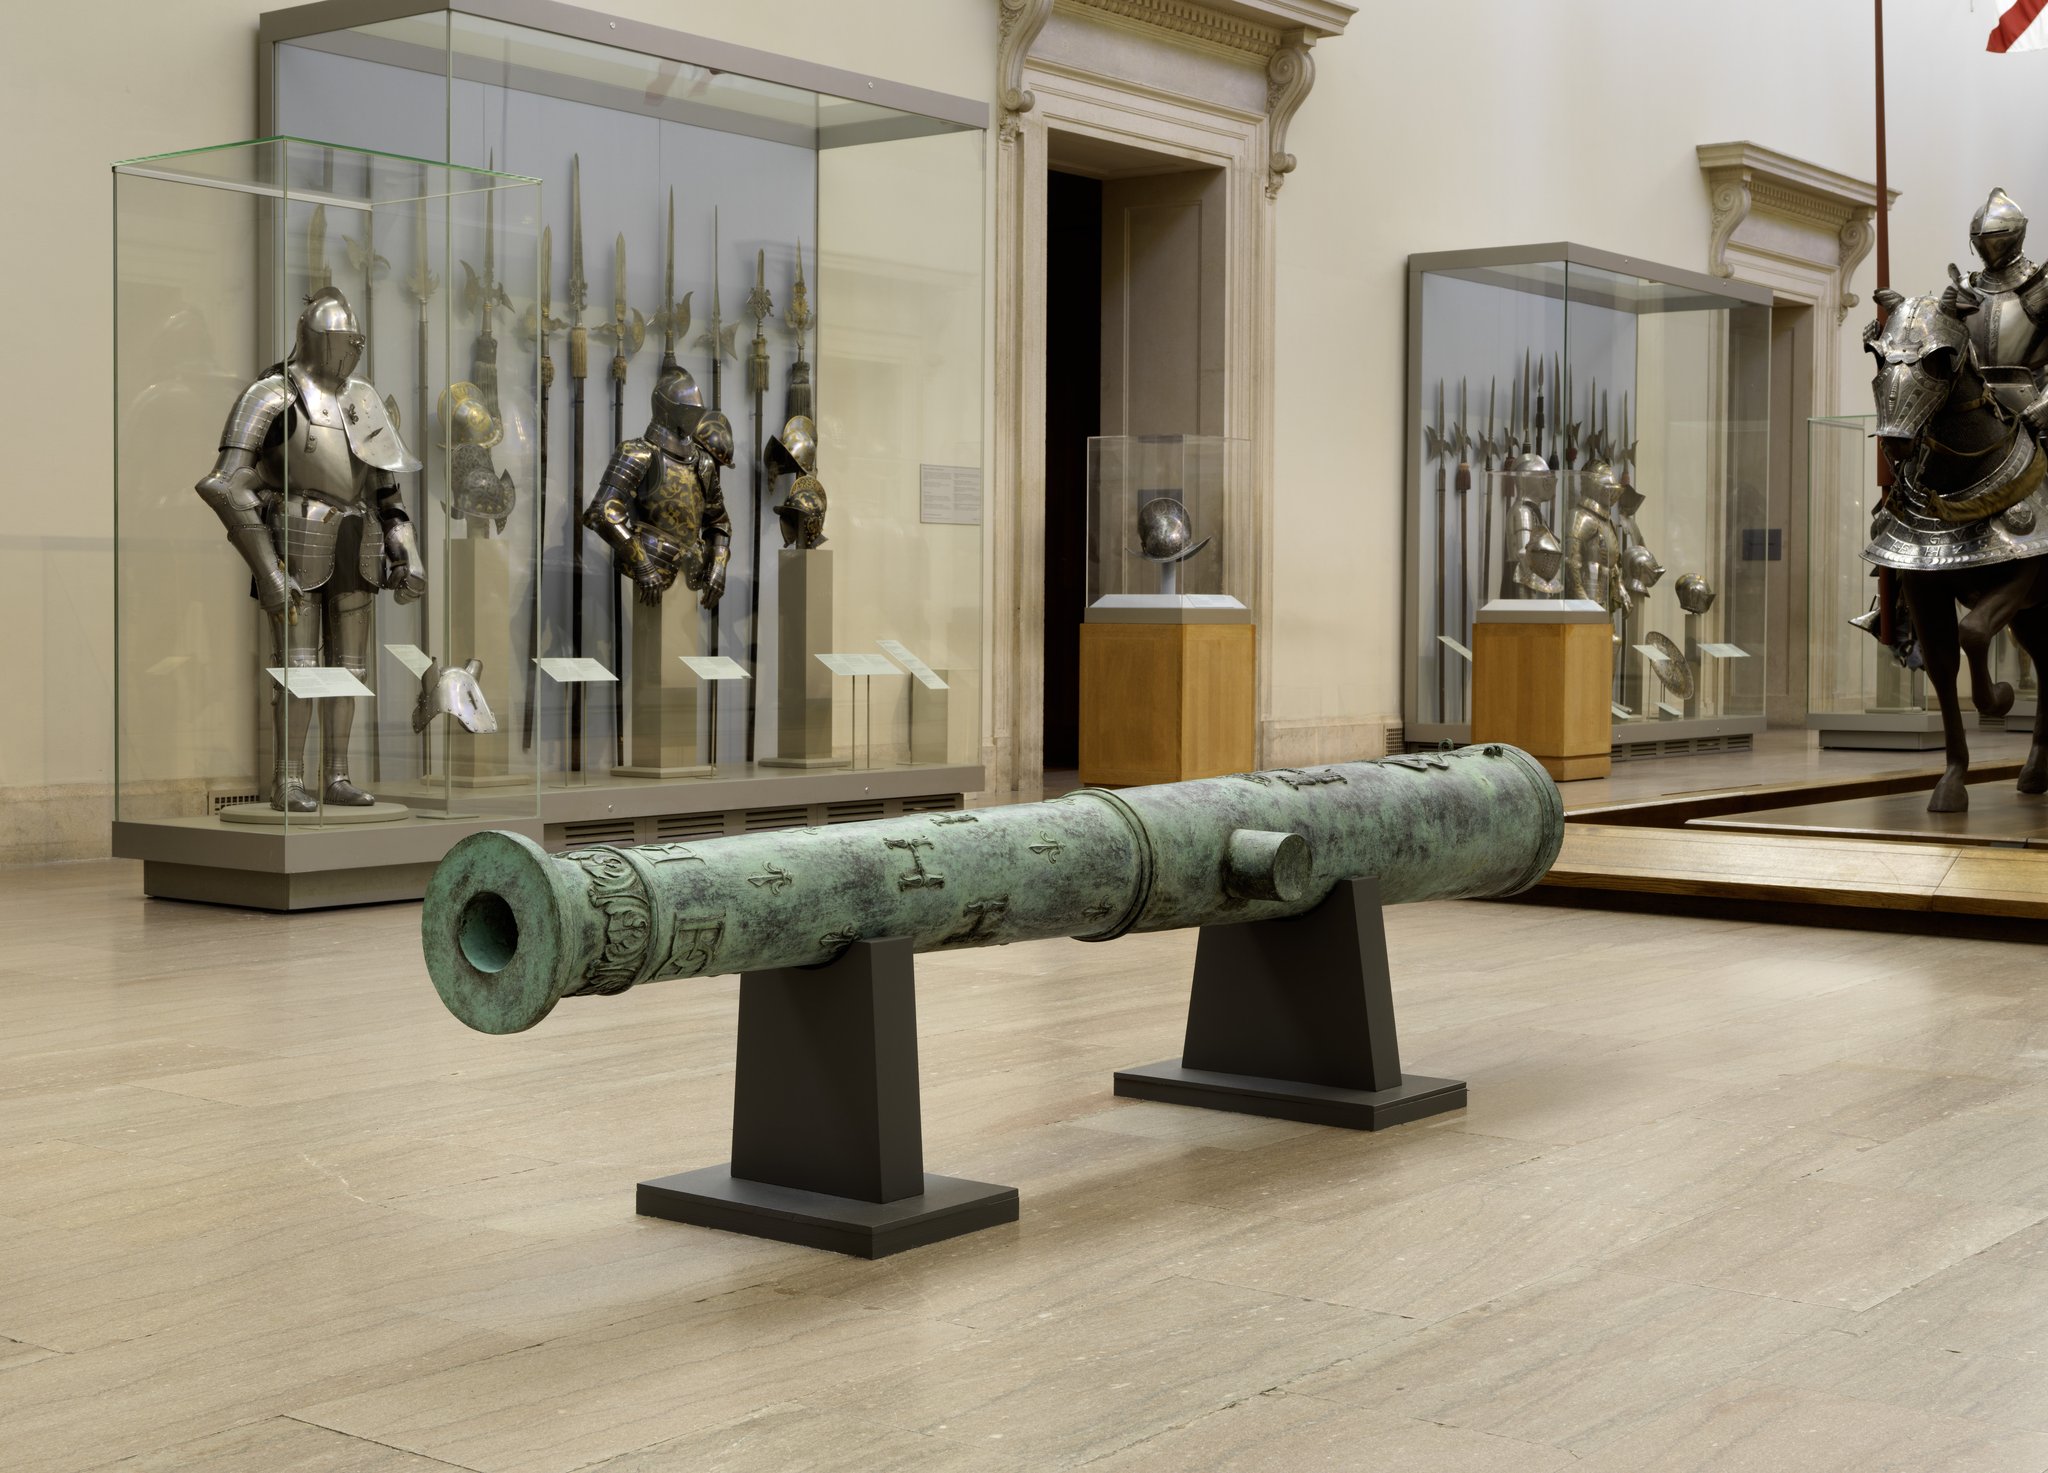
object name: cannon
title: Cannon (Bastard Culverin) Made for Henry II, King of France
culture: french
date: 1550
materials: bronze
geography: france